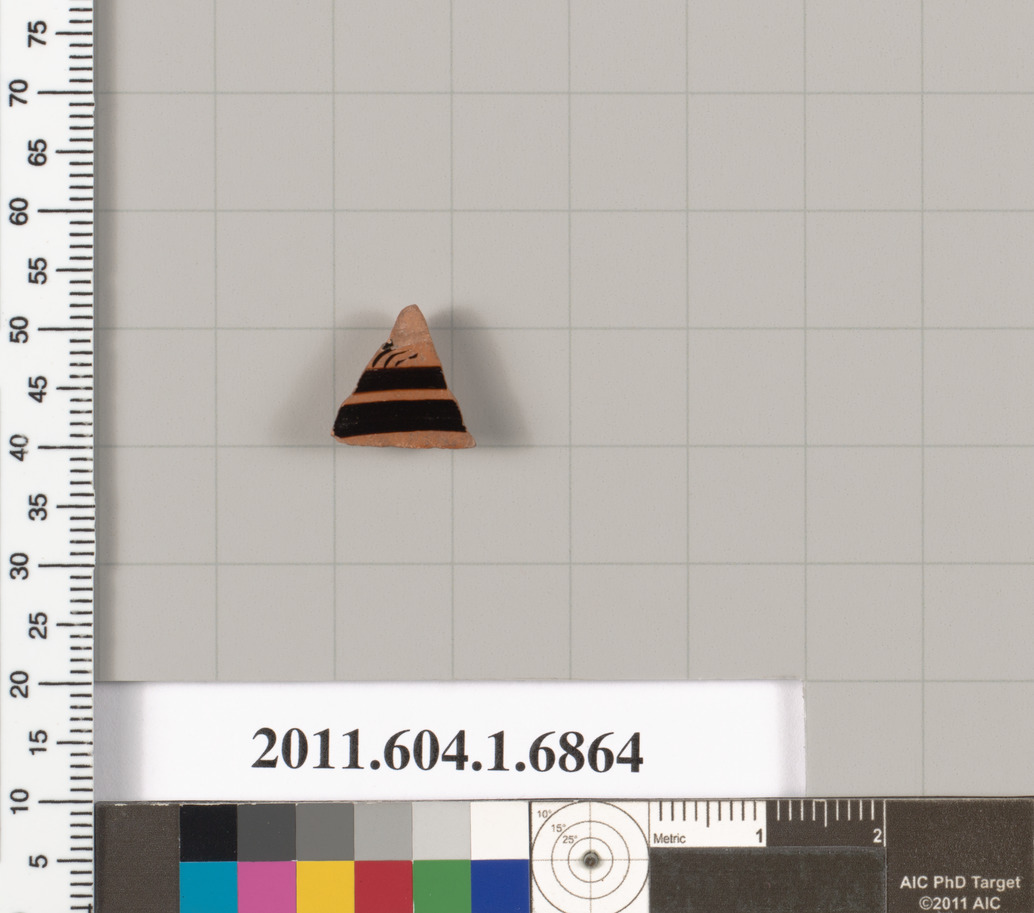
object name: kylix fragment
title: Terracotta fragment of a kylix (drinking cup)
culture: greek, attic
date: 490-470 BCE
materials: terracotta